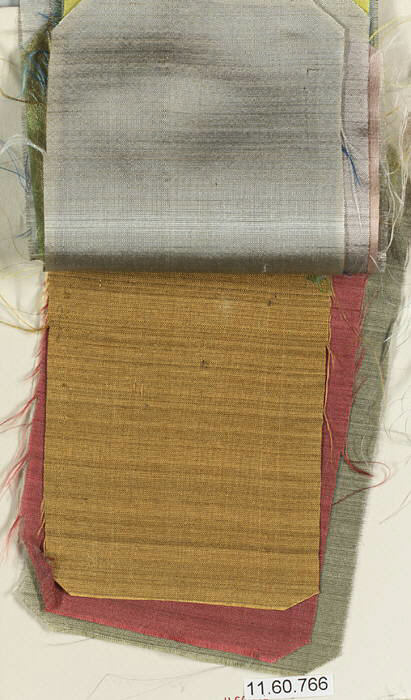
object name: sample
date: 1801-1833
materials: silk